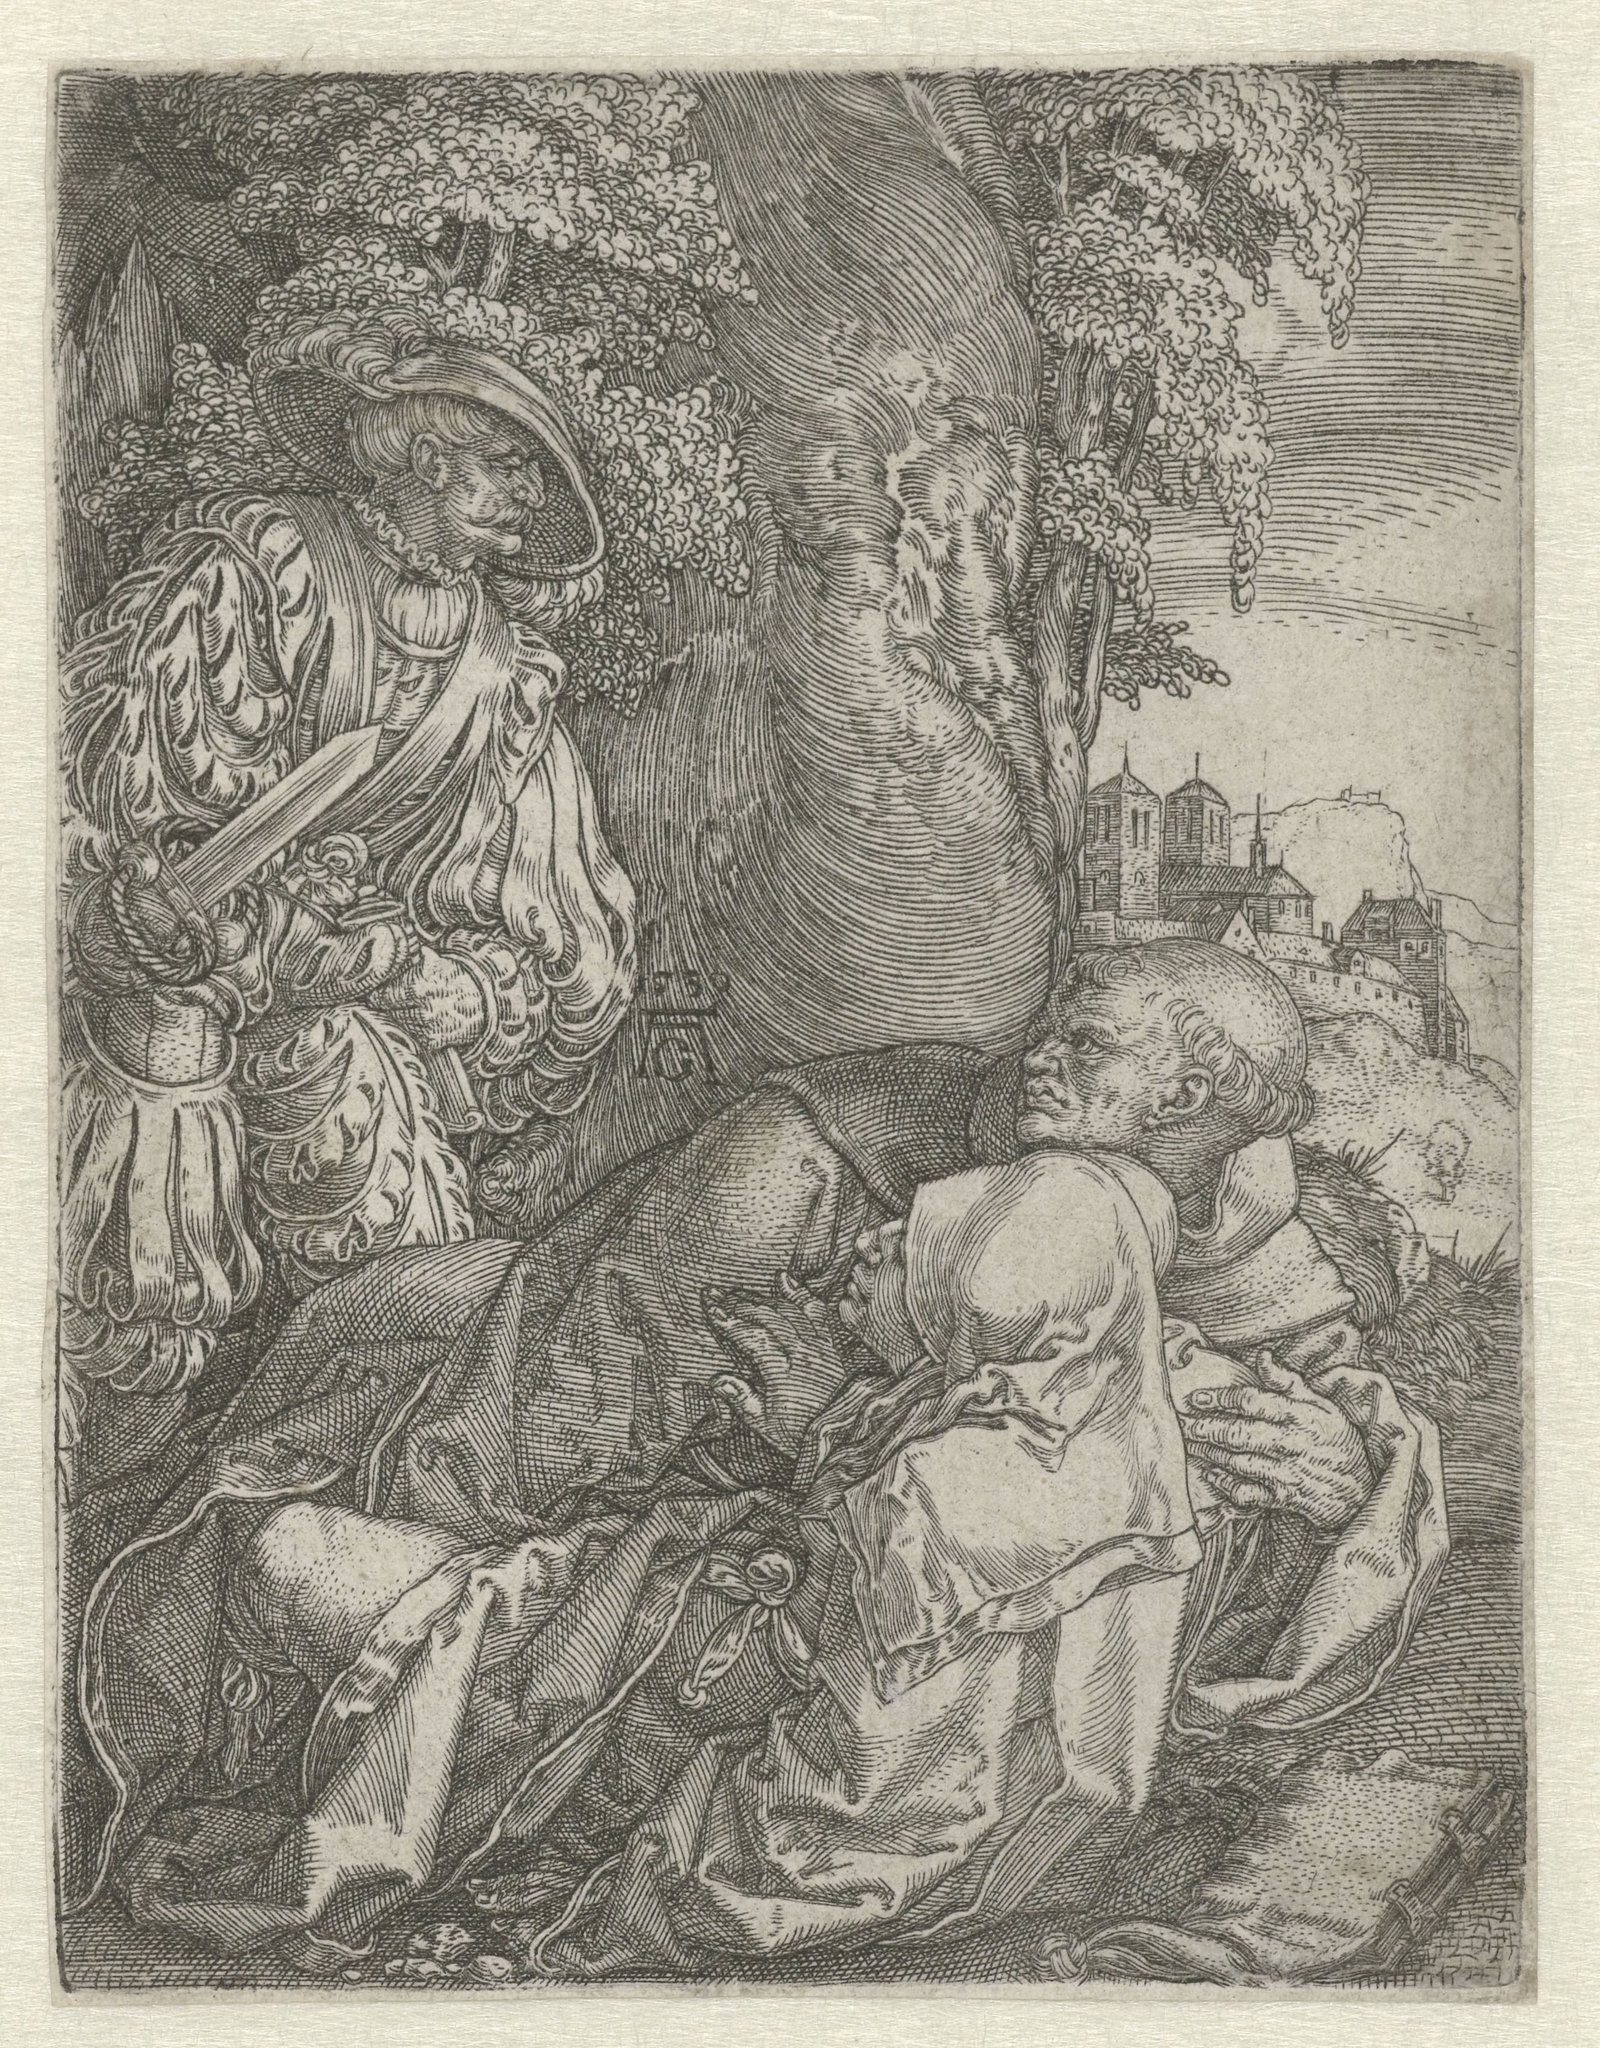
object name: print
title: De monnik en de non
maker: heinrich aldegrever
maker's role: draughtsman, print maker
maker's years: 1502-1561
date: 1530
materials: paper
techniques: engraving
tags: man and woman cohabiting, monks and nuns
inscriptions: number: ‘94’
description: Monnik en een non vrijend onder een boom, worden betrapt door een soldaat.